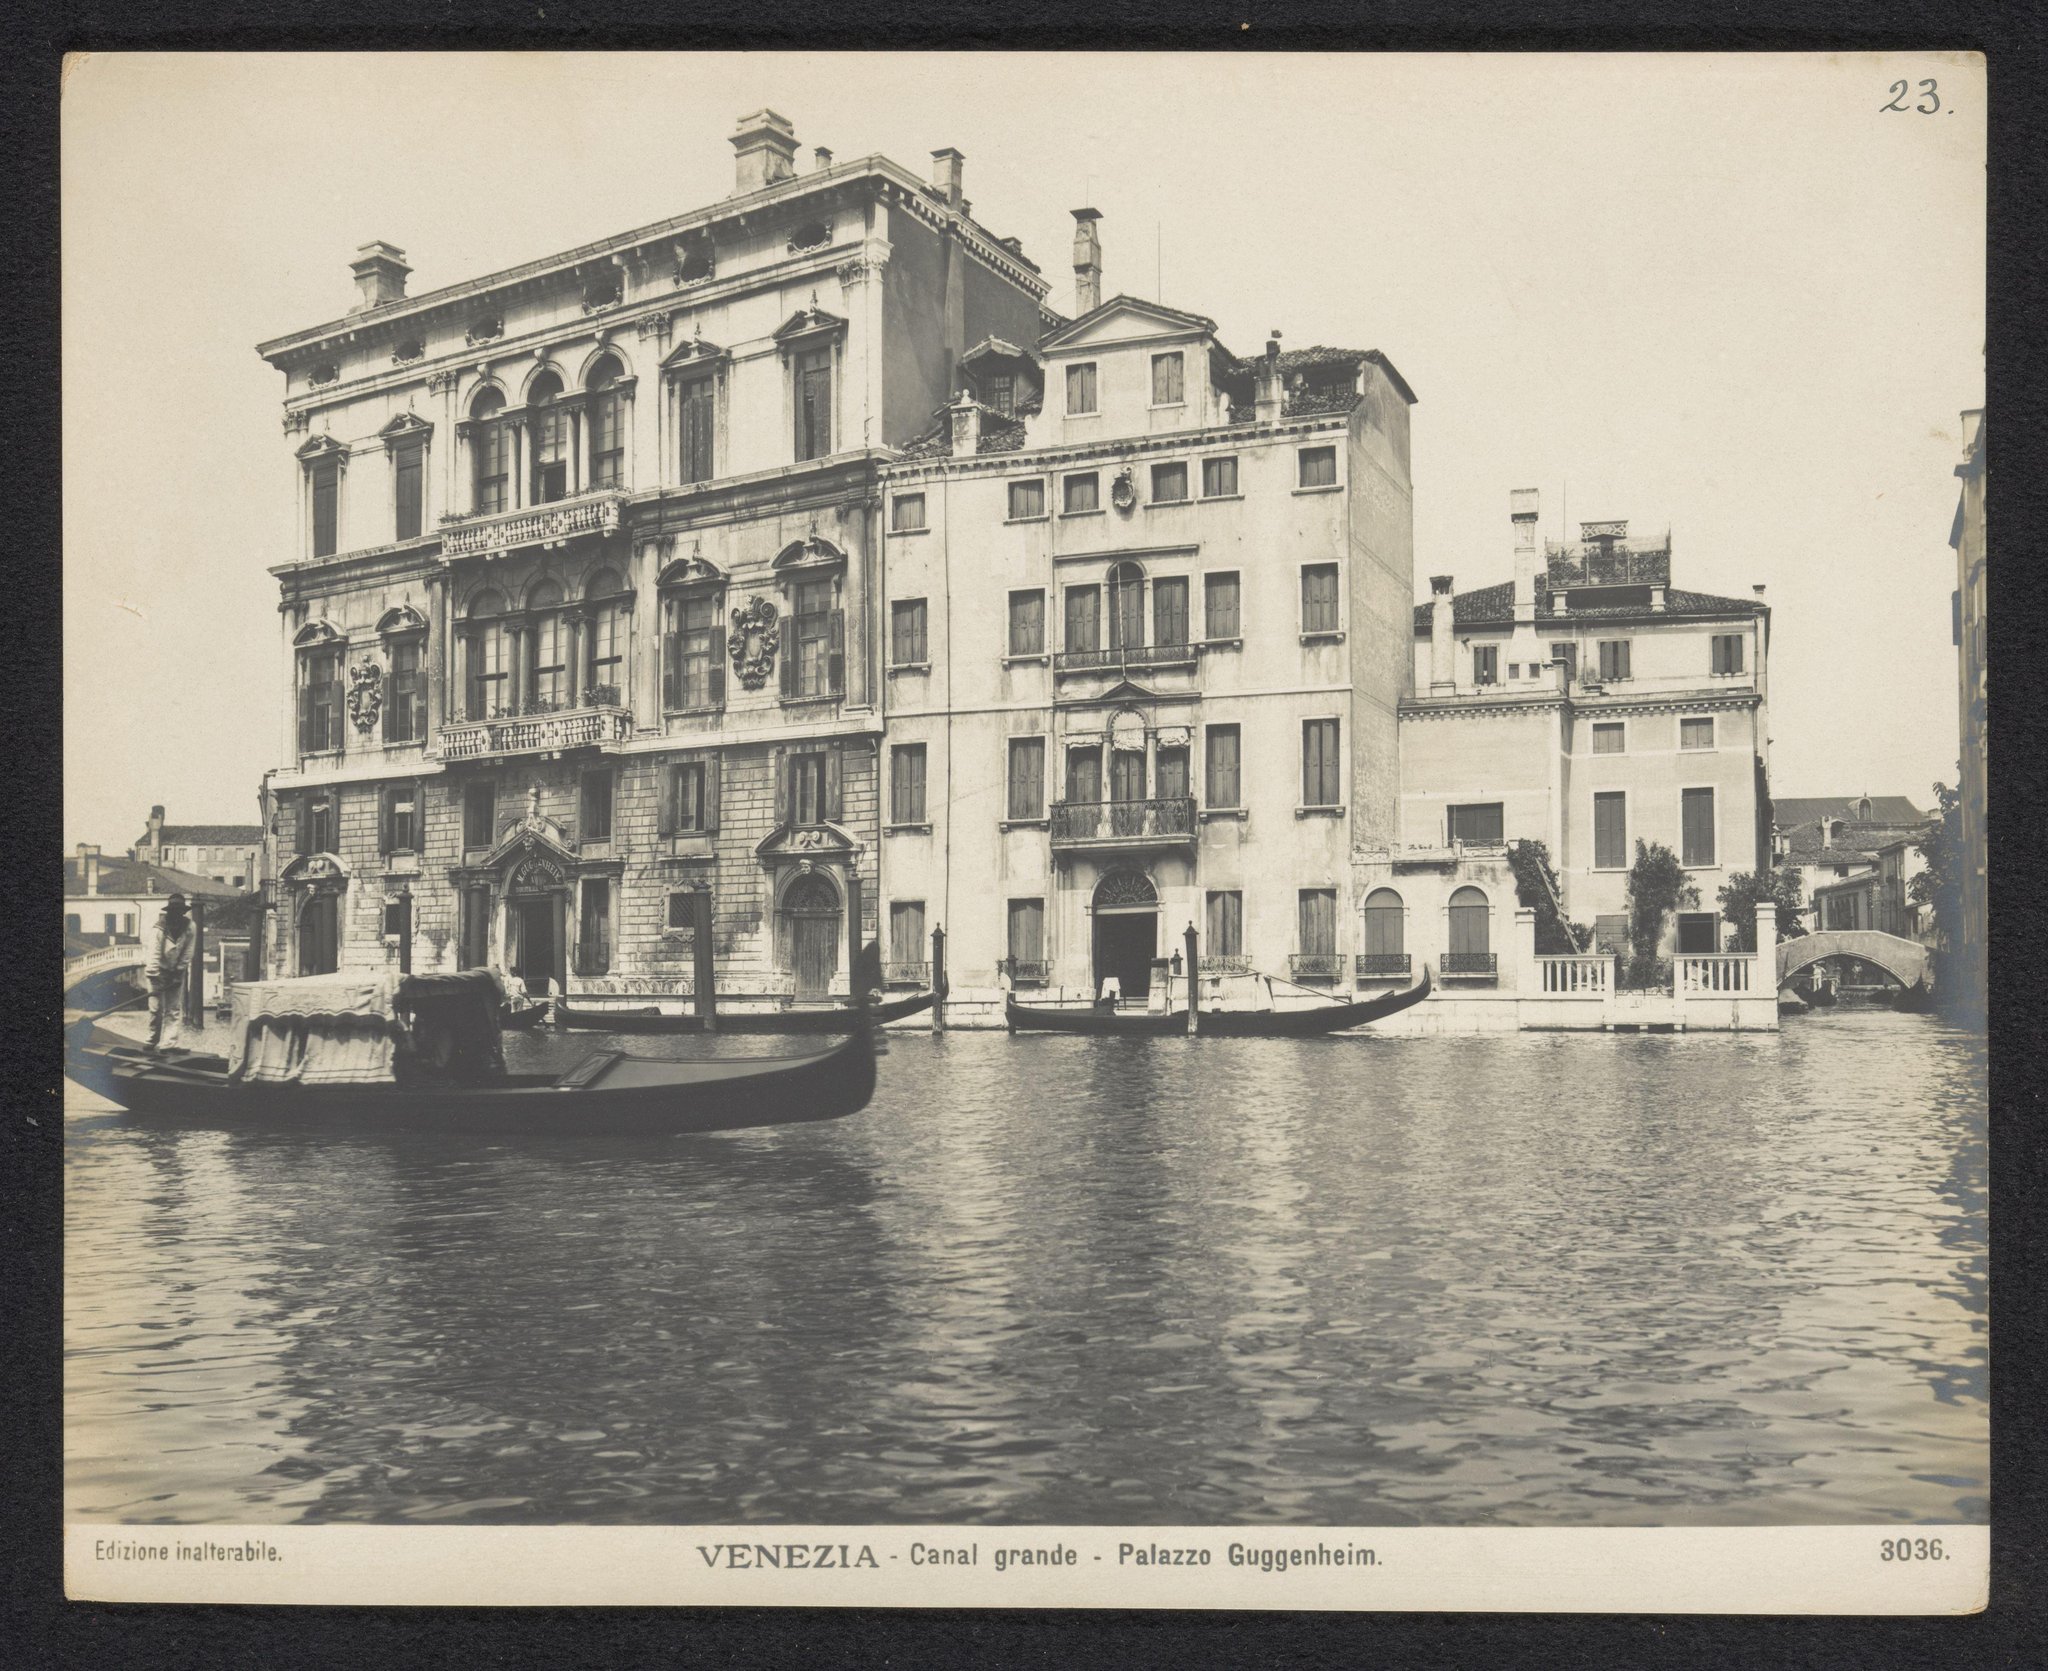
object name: photograph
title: Venezia - Canal grande - Palazzo Guggenheim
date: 1900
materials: cardboard, photographic support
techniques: gelatin silver print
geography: venice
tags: hôtel, i.e. small palace in city, façade (of house or building)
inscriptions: number: ‘3036.’, number: ‘23.’